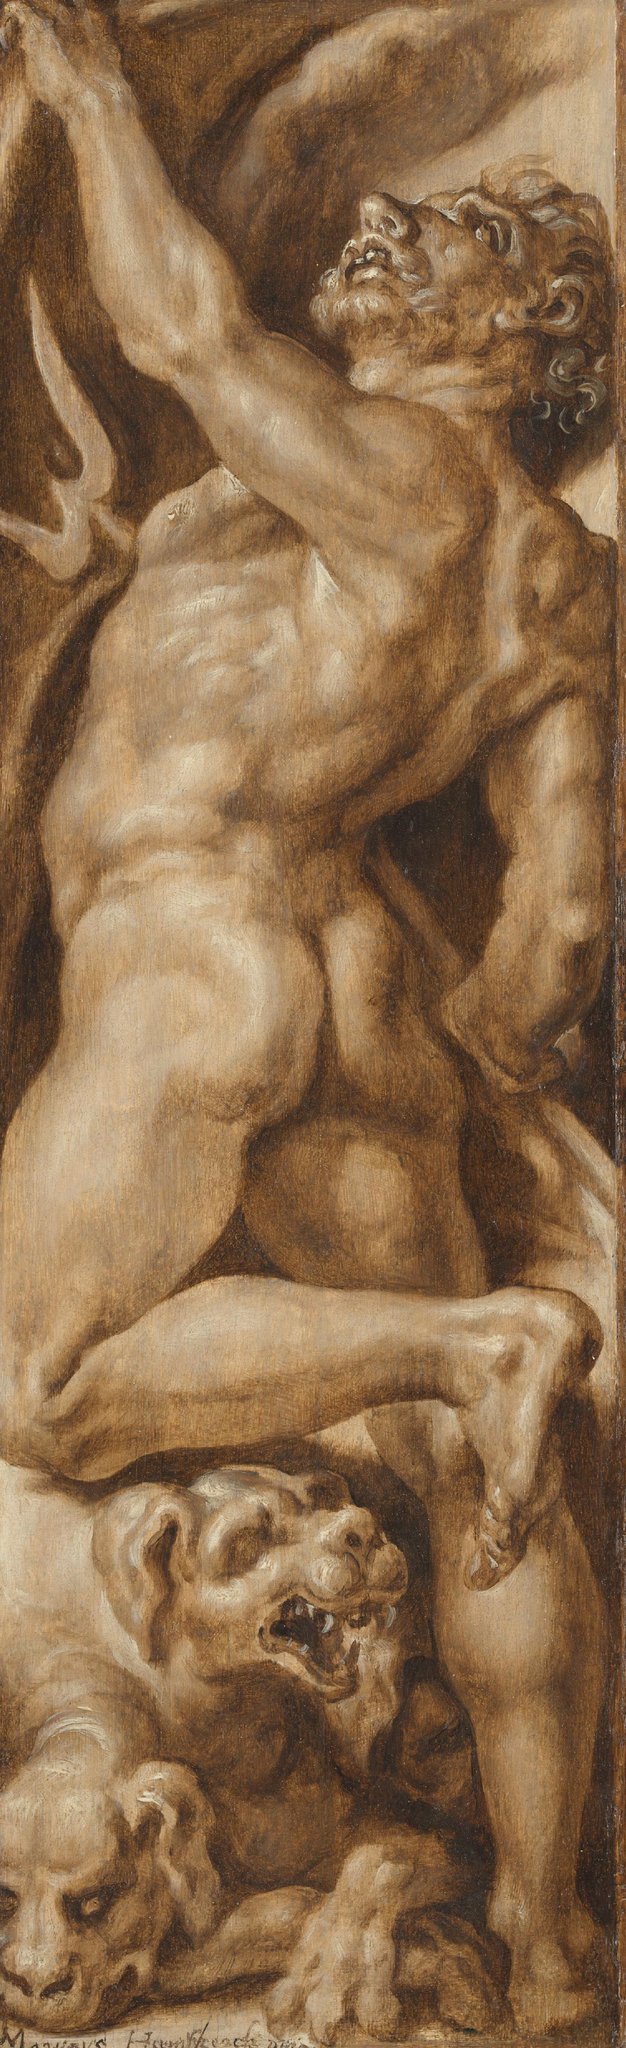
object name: painting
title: Triumph over Evil: Samson Rending the Lion | Pluto and Cerberus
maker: martinus van heemskerck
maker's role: draughtsman, painter, print maker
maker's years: 1498-1574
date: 1555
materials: oil, paint, panel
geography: haarlem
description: The young, beardless Samson ripped a ferocious lion apart with just his bare hands. In Heemskerck’s time, this story was regarded as the forerunner (prefiguration) of Christ’s victory over the devil. Pluto, recognizable by his three-headed dog Cerberus, was the guardian of the underworld in classical mythology. In the 16th century he was also identified with the devil from Christianity.